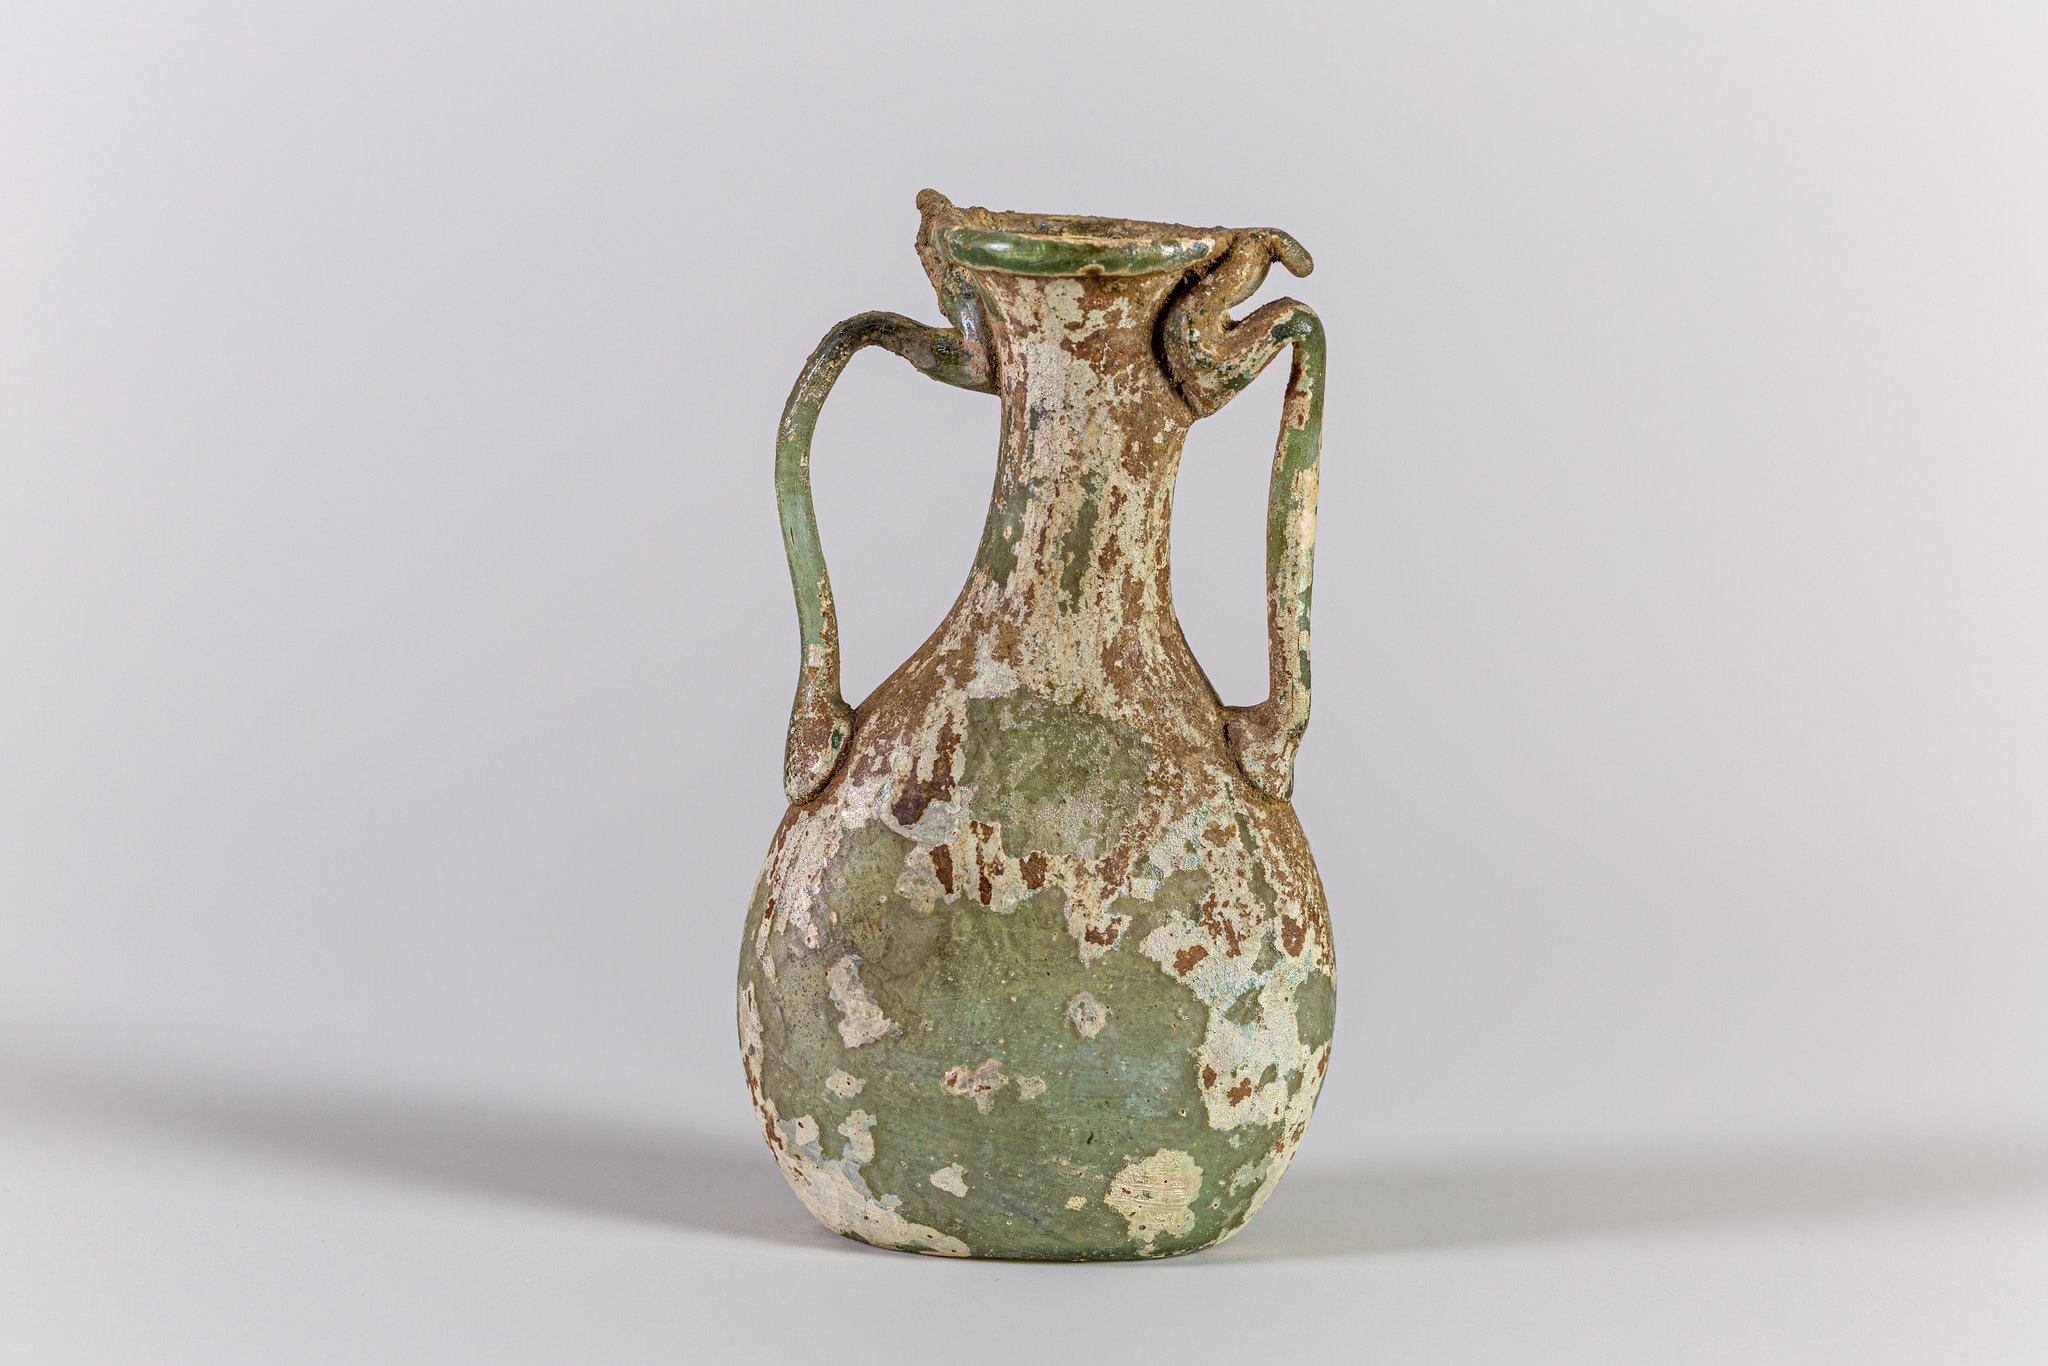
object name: bottle, two handled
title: Glass two-handled bottle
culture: roman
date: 301-400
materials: glass